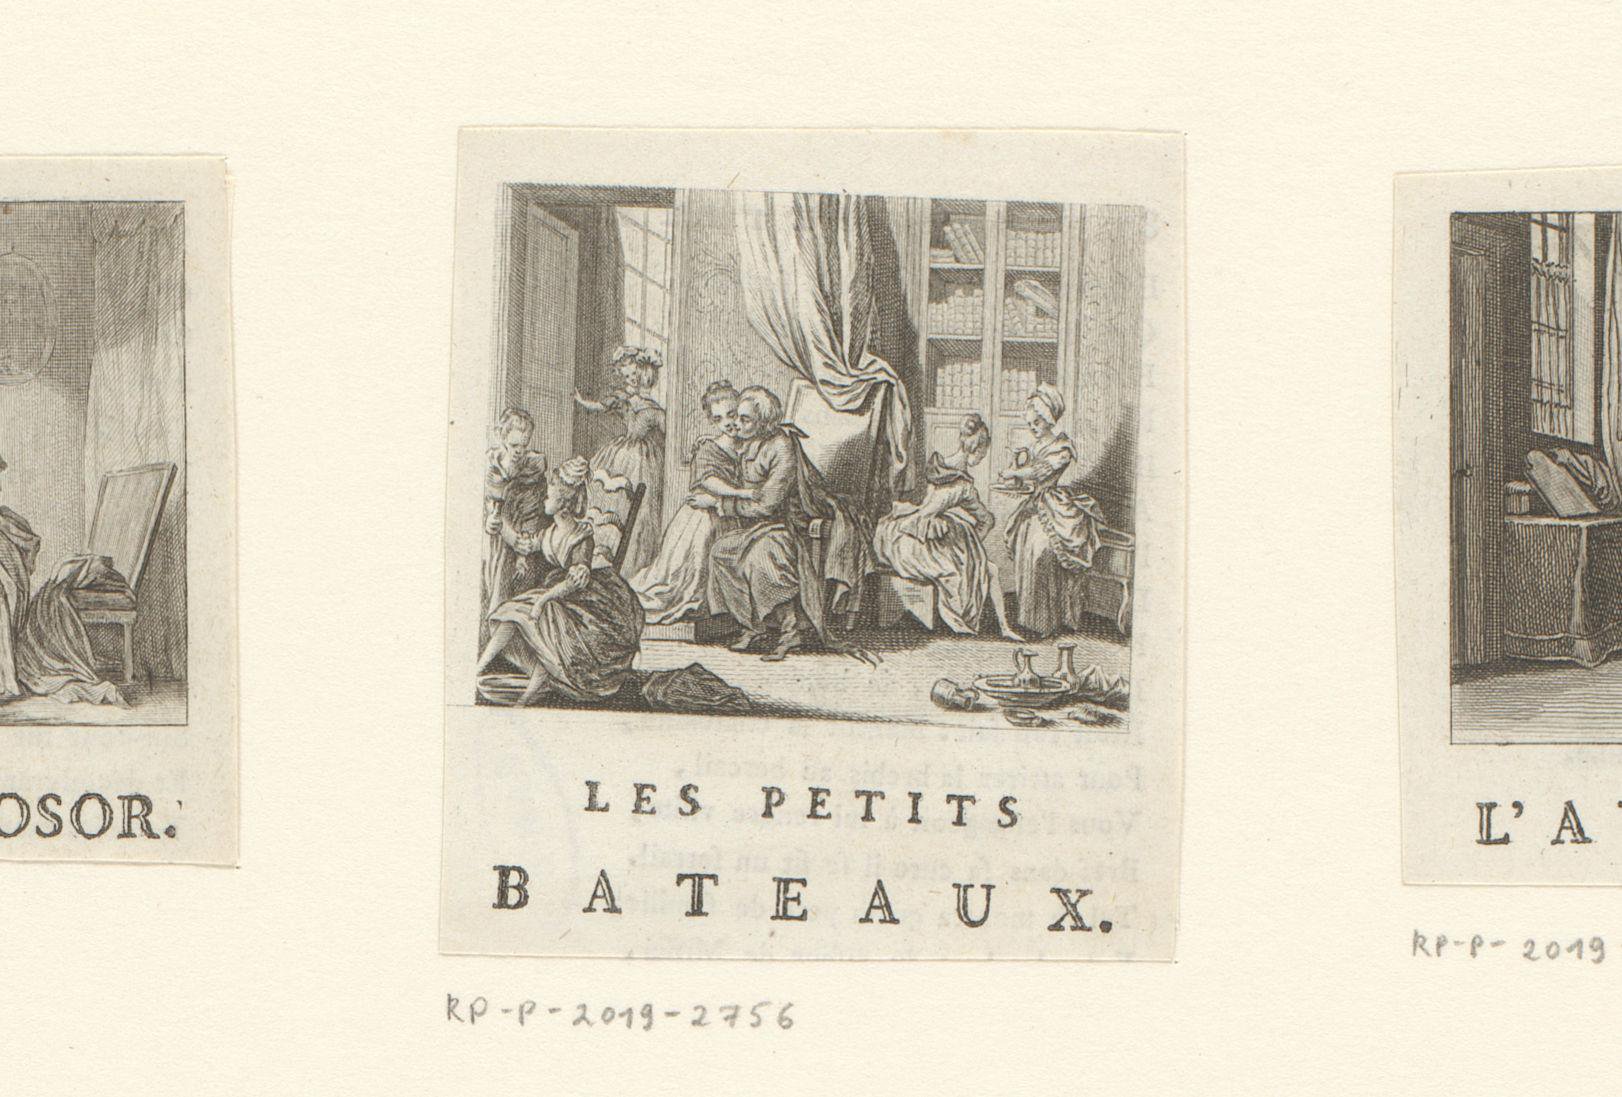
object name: book illustration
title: Koppel in omhelzing in een kamer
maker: Anonymous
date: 1763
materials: paper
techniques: engraving, etching, letterpress printing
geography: france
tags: couple of lovers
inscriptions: collector's mark: Lugt 2228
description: Mogelijk prent uit: Grecourt, Jean Baptiste Joseph Willart de. Oeuvres diverses de M. de Grécourt, nouvelle édition, augmentée d'un grand nombre de pièces, revus sur les originales et du Philotanis. Amsterdam: s.n., 1763.